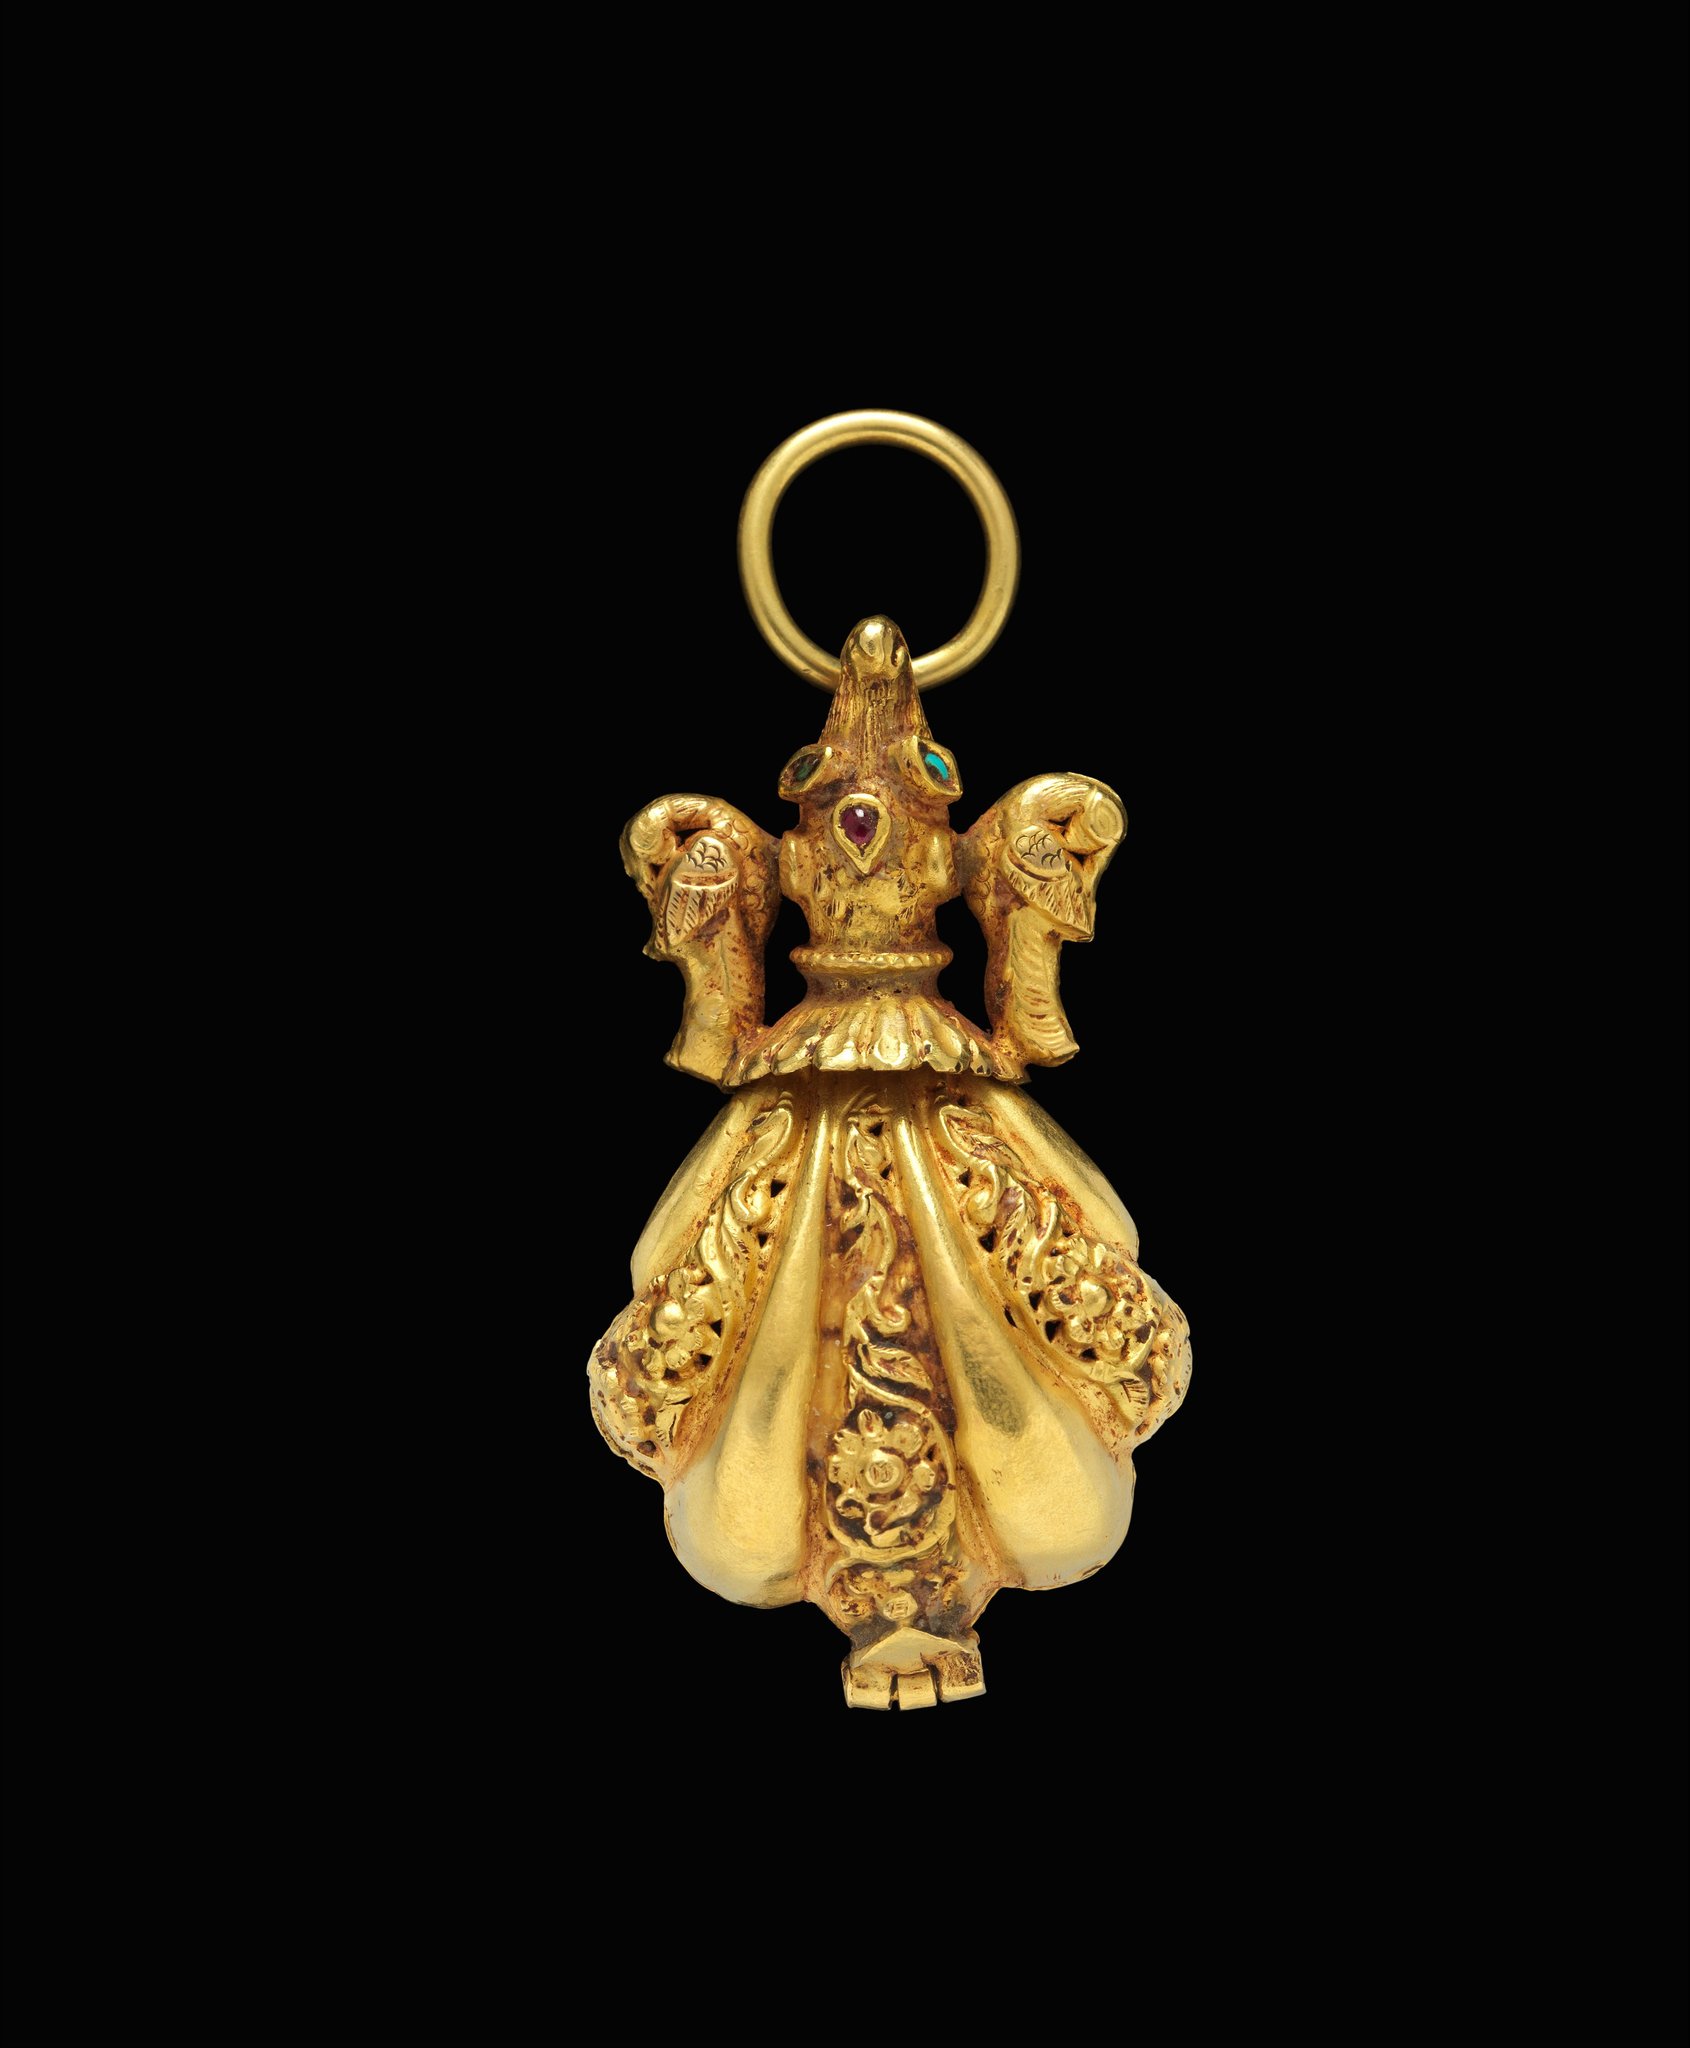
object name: pendant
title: Locket Pendant, Possibly a Pomander, in Shape of Shell with Animal-Headed Cap Flanked by a Small Bird on Sides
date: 1601-1700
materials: gold, gemstone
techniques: casting, embossing, engraving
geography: india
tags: birds,shells